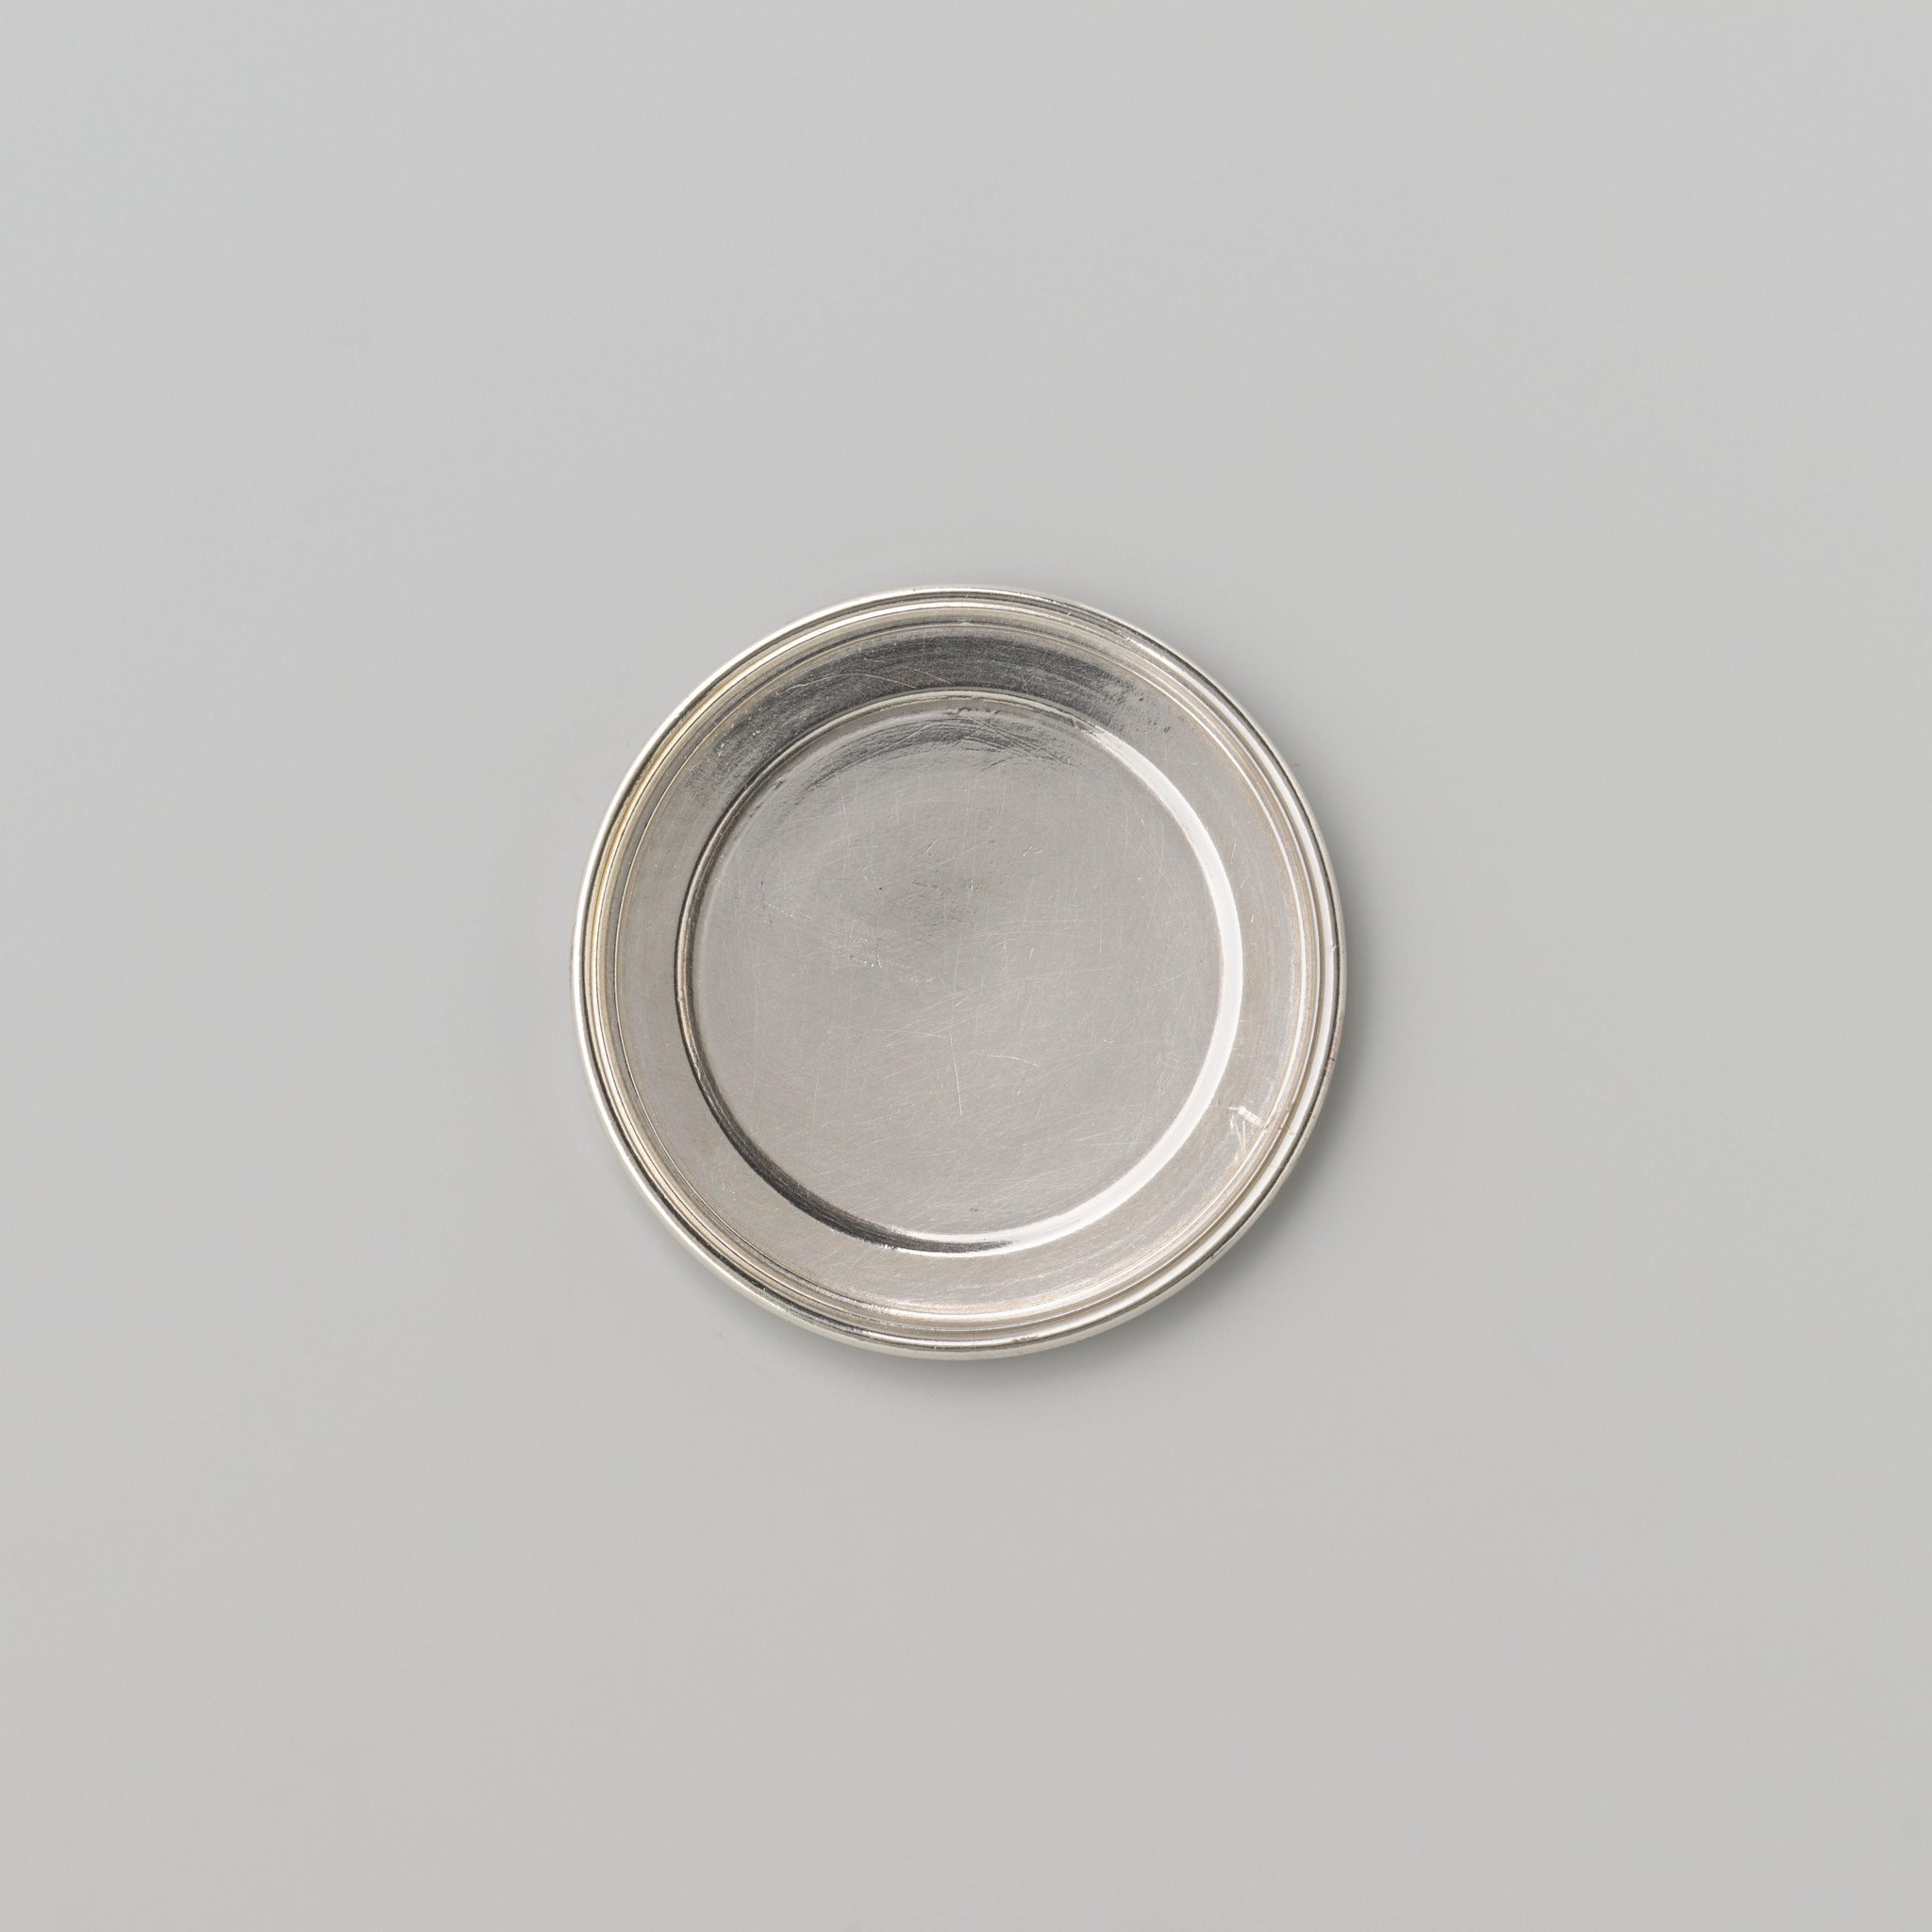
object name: platter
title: Zilverkleurige schotel met smalle platte geprofileerde rand.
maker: Anonymous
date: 1700-1710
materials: copper alloy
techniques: silvering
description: Zilverkleurige schotel met smalle platte geprofileerde rand.